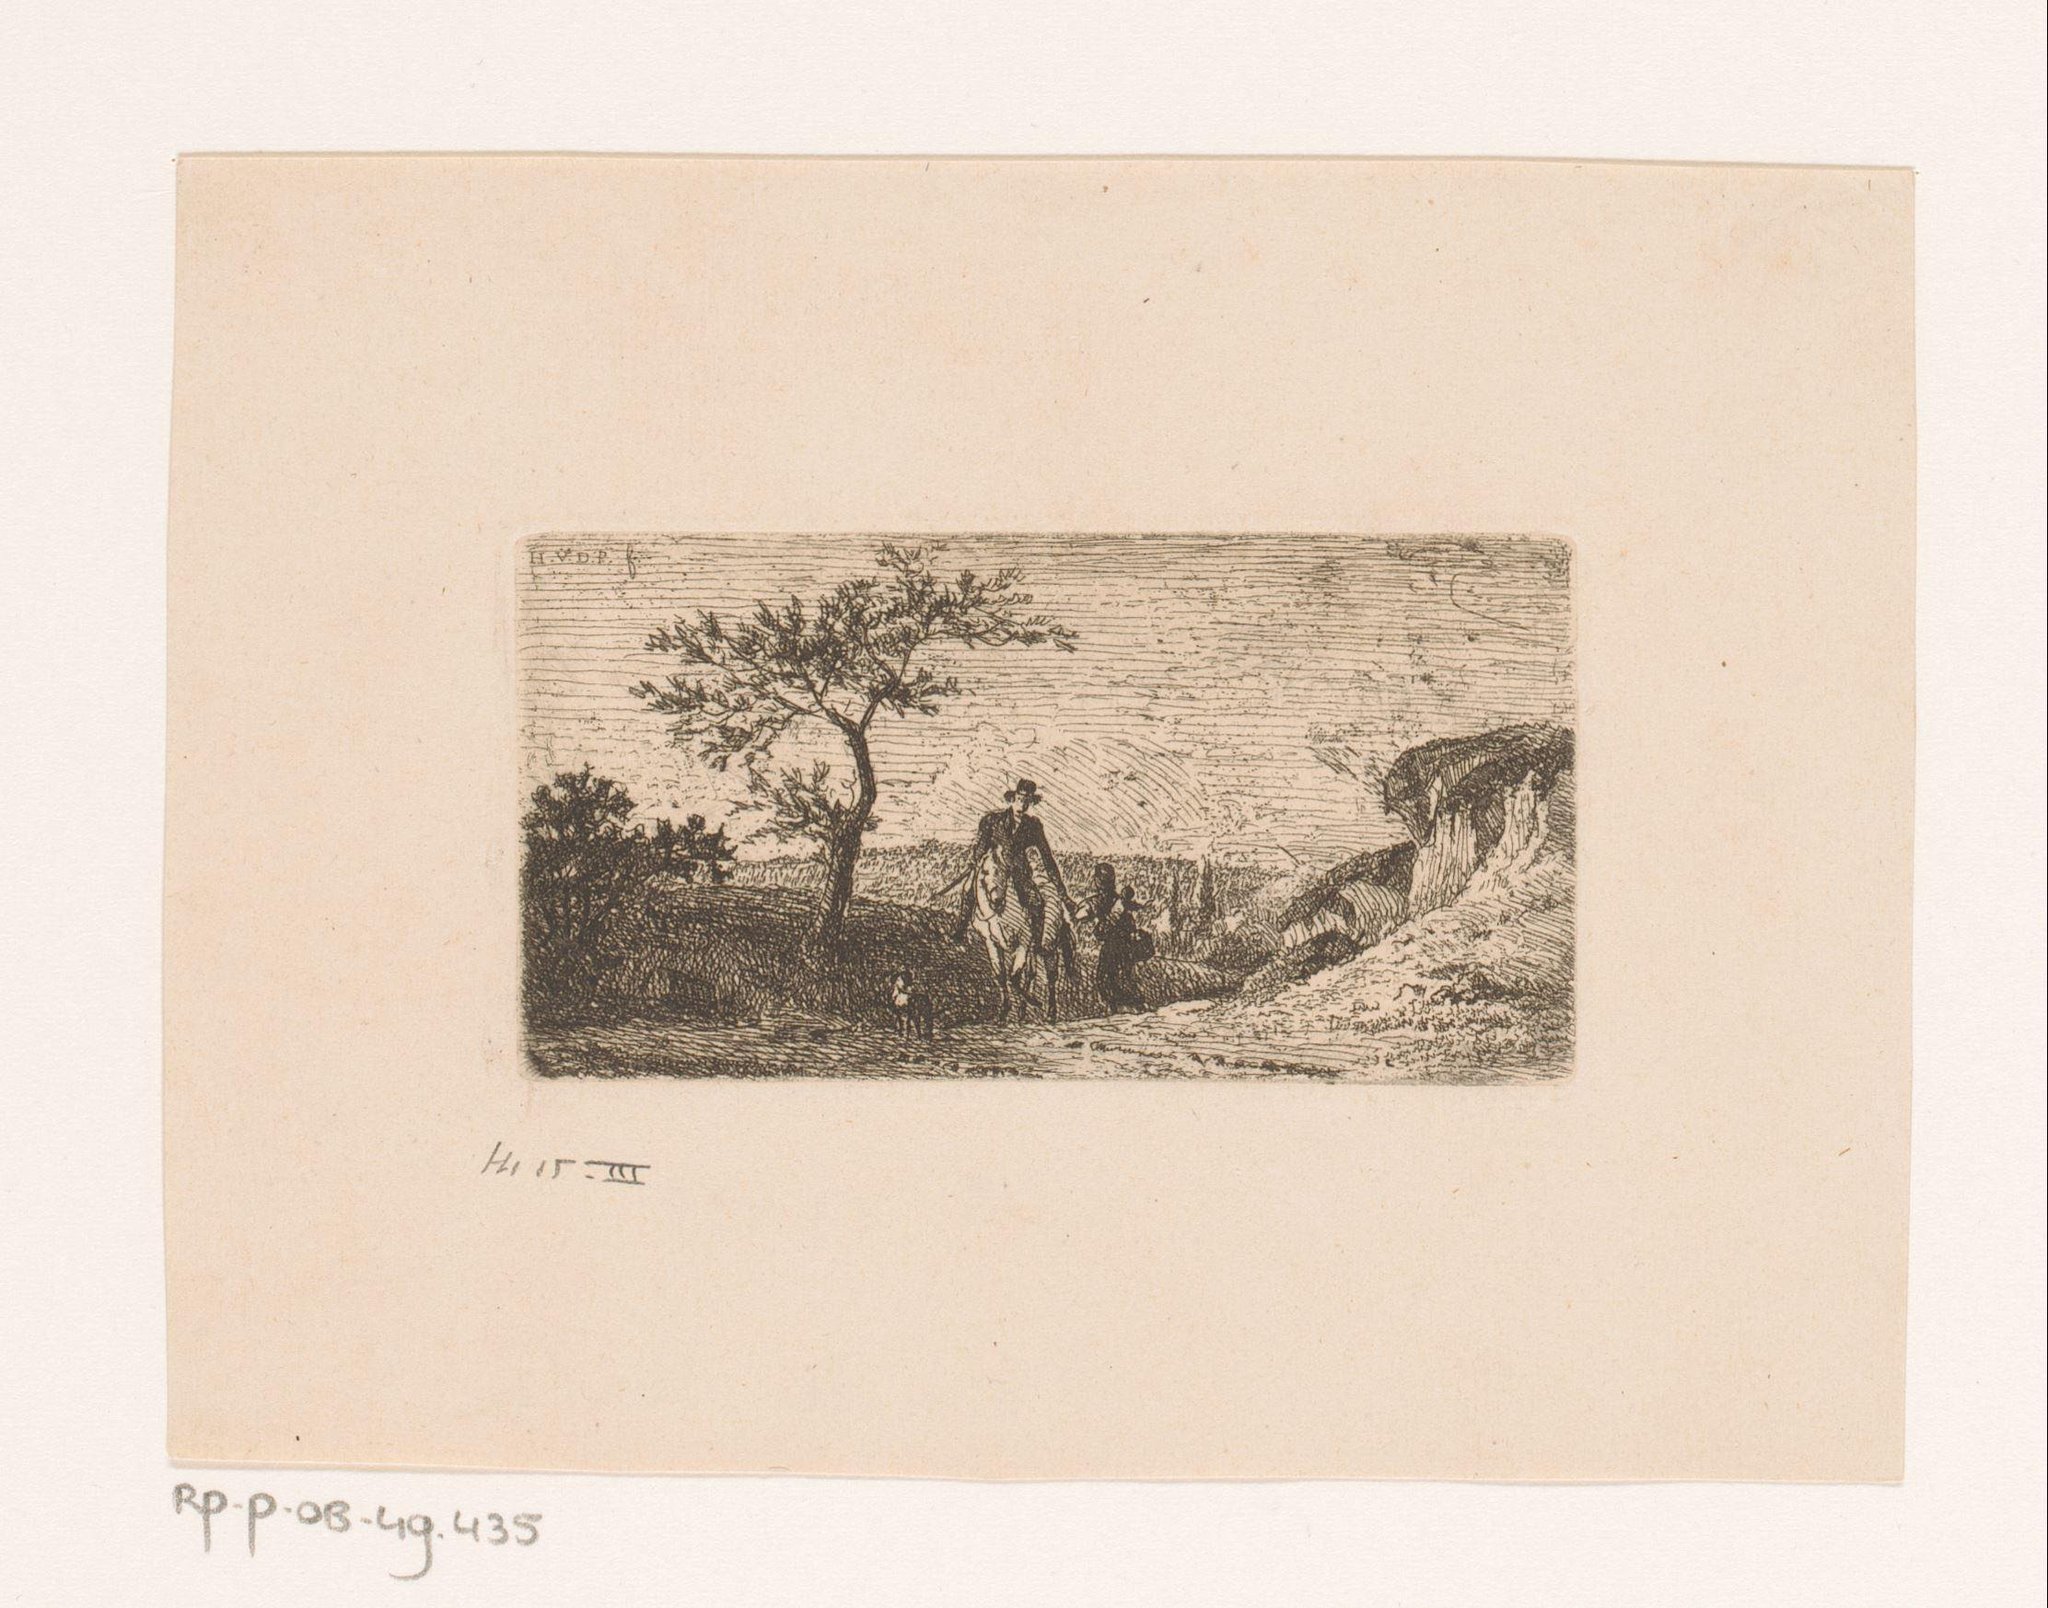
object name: print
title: Landschap met ruiter en bedelaarster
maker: hendrik jozef franciscus van der poorten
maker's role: draughtsman, print maker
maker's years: 1789-1874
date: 1799-1874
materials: paper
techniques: etching, intaglio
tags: riding a horse, ass, or mule; rider, horseman, road, path, beggar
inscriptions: collector's mark: Lugt 2228